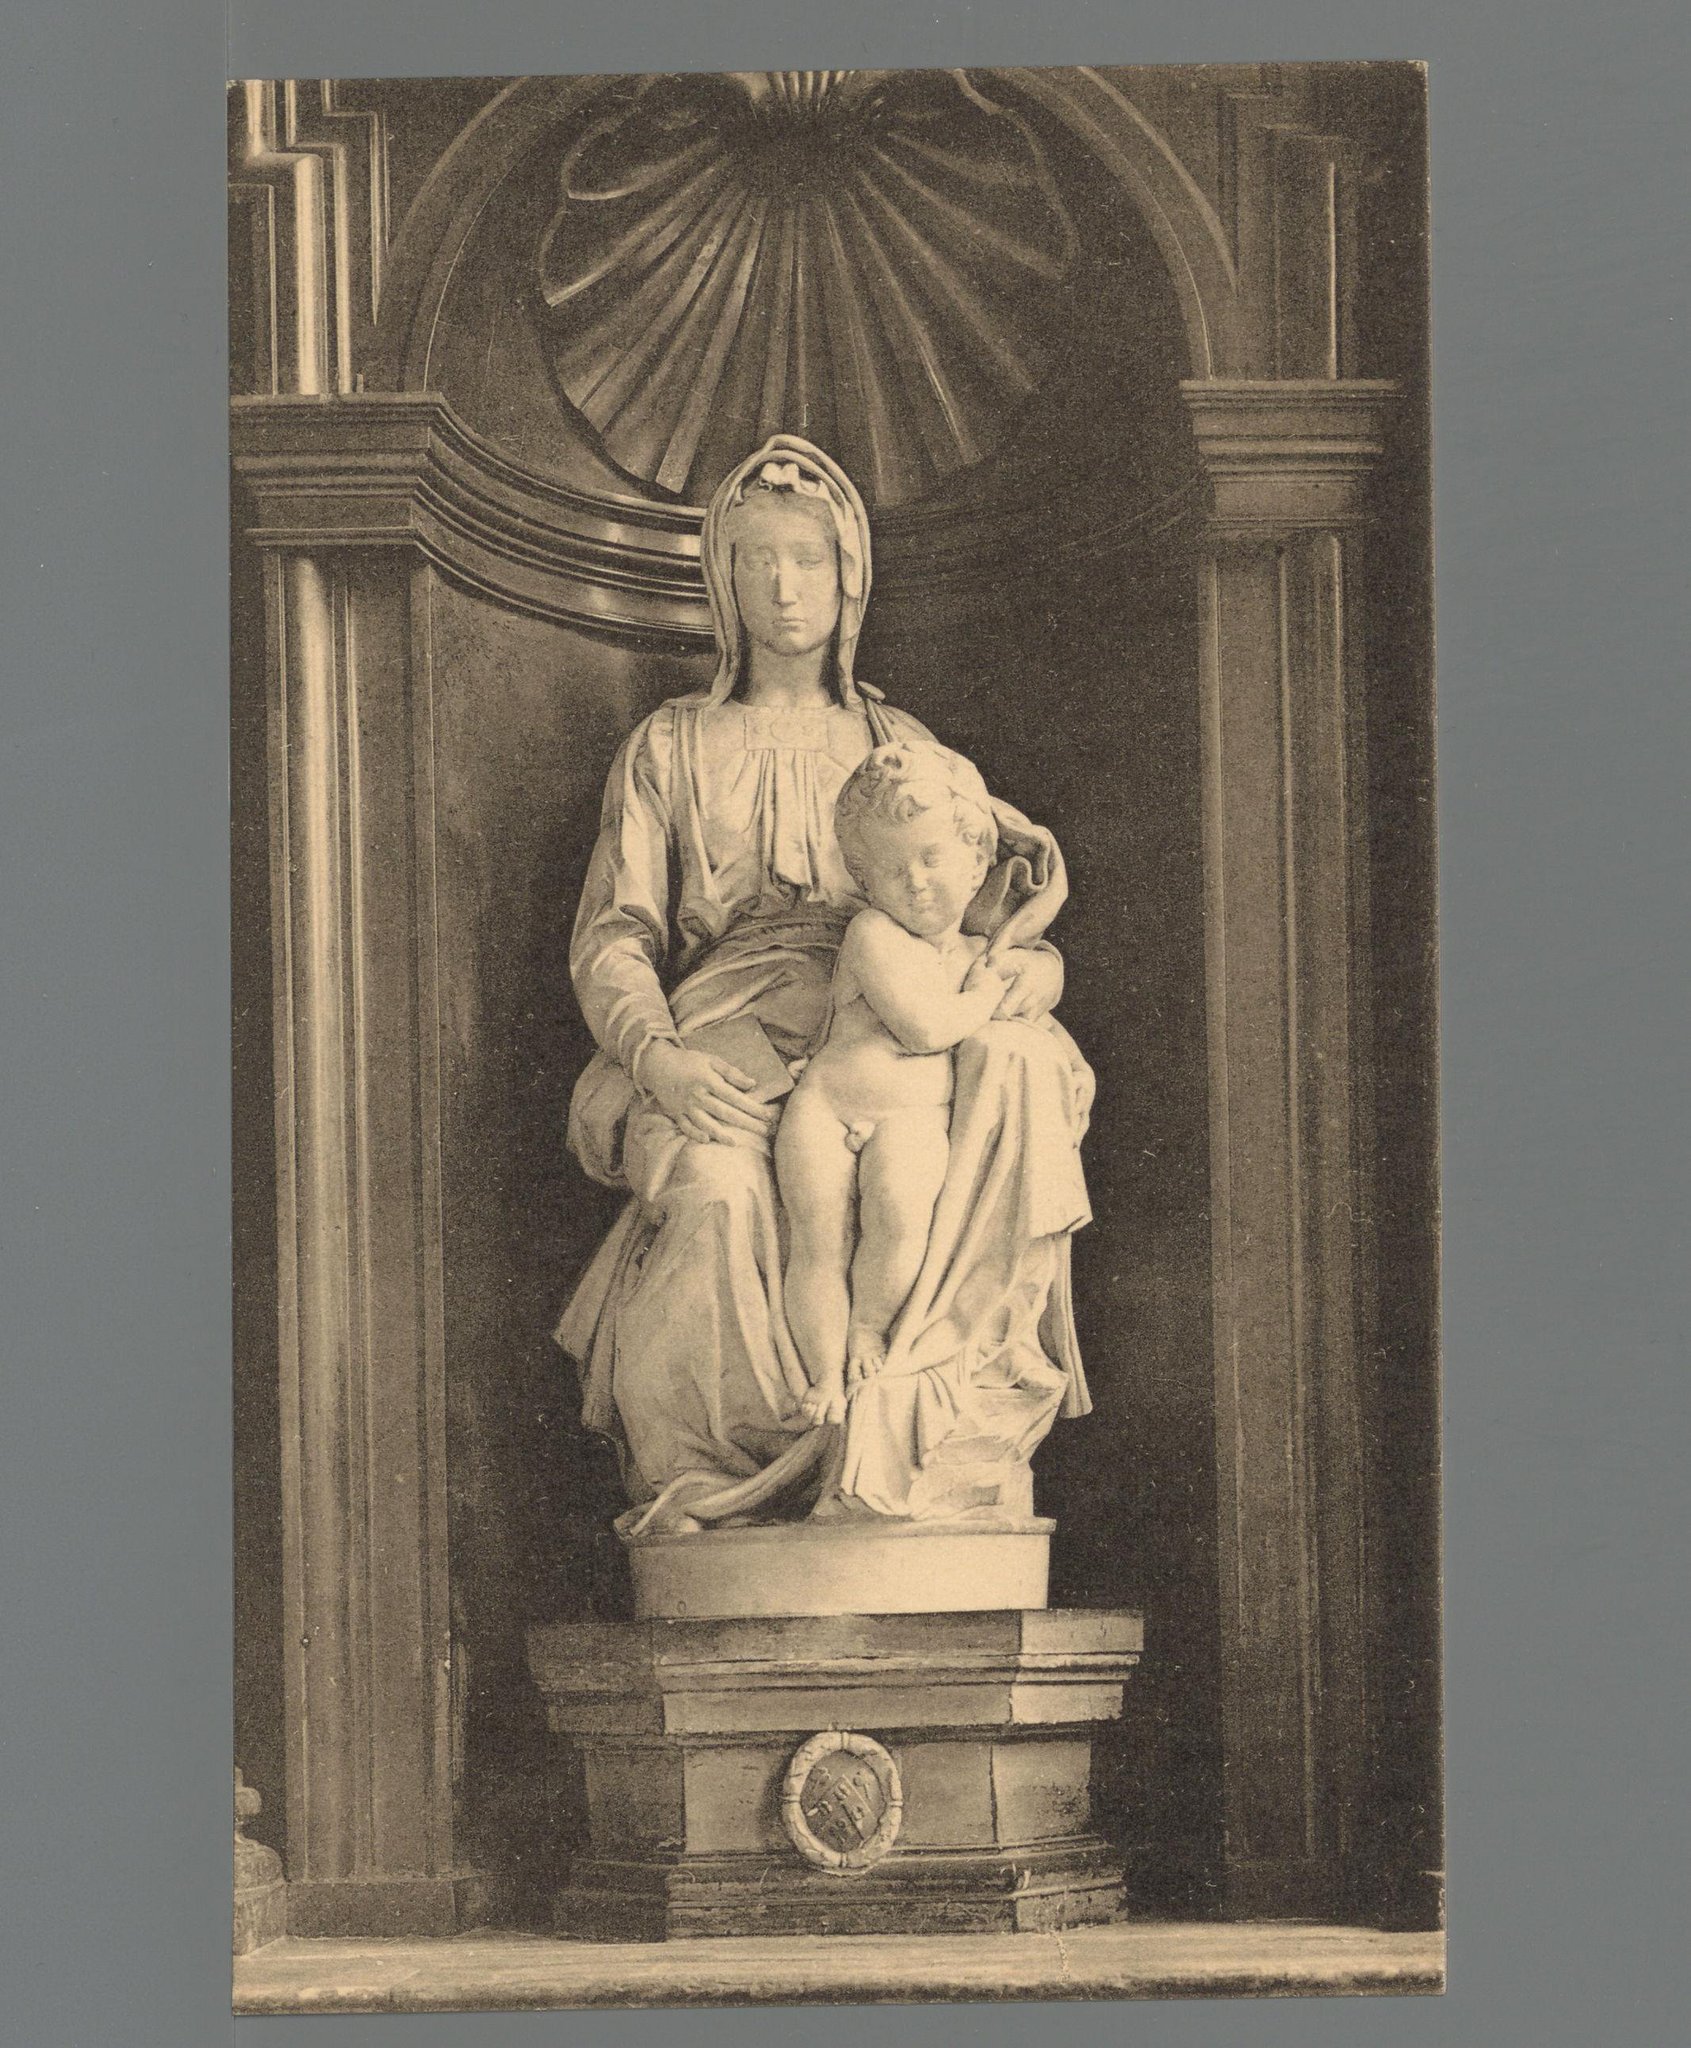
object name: photomechanical print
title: Série 12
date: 1913-1930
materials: cardboard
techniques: photograph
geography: brussels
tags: madonna: i.e. mary with the christ-child, church (exterior), monument, statue